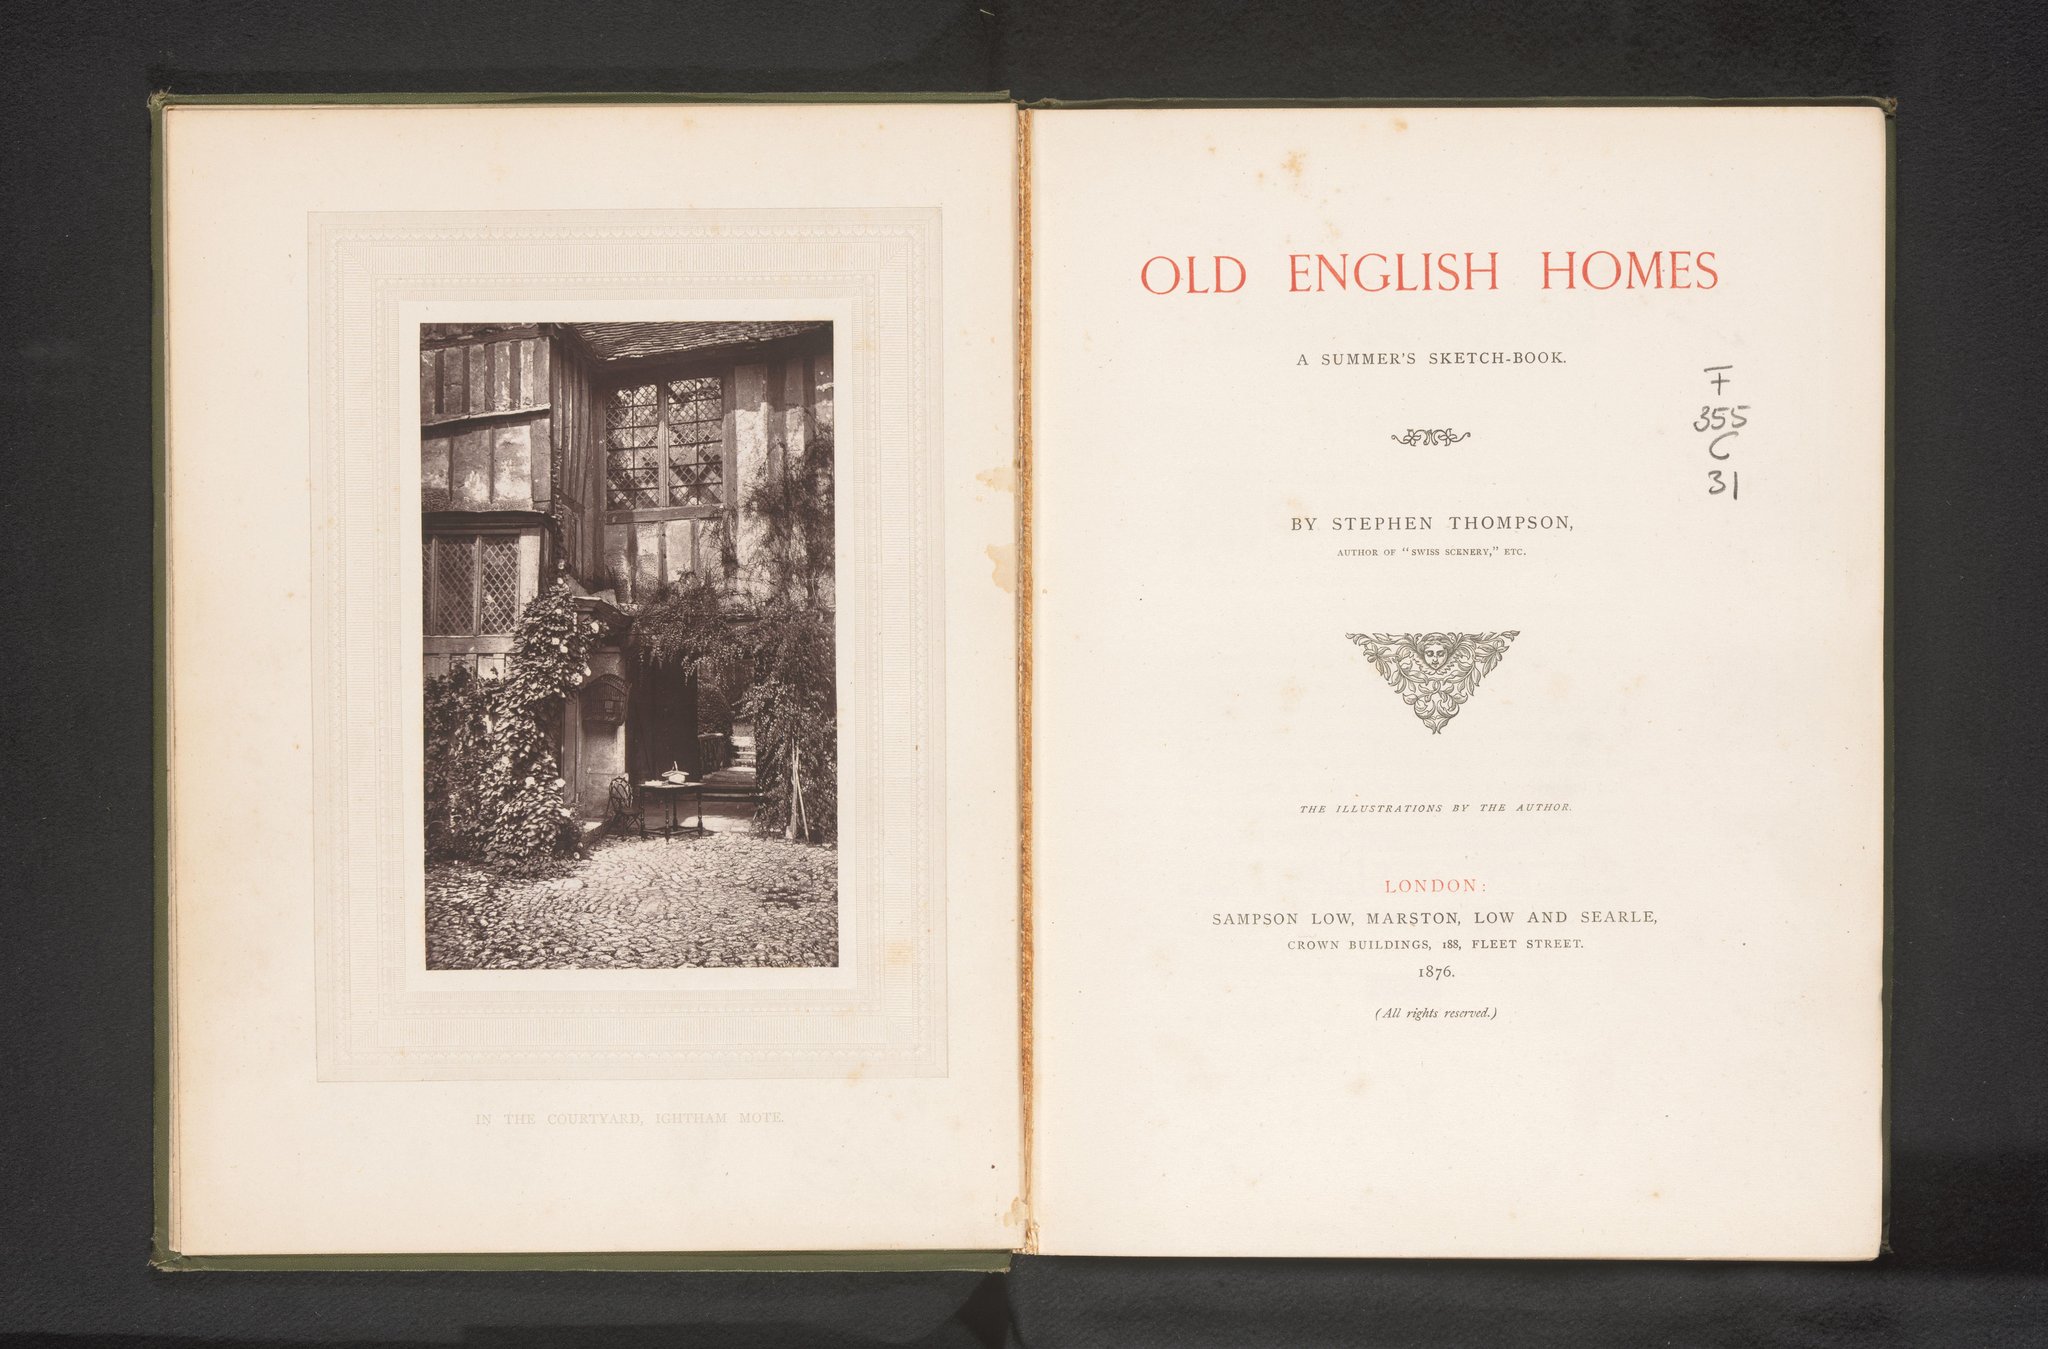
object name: photomechanical print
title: Binnenplaats van Ightham Mote vlakbij Ightham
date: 1866-1876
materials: paper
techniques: woodburytype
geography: ightham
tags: rural housing, e.g. country-house, villa, cottage, courtyard